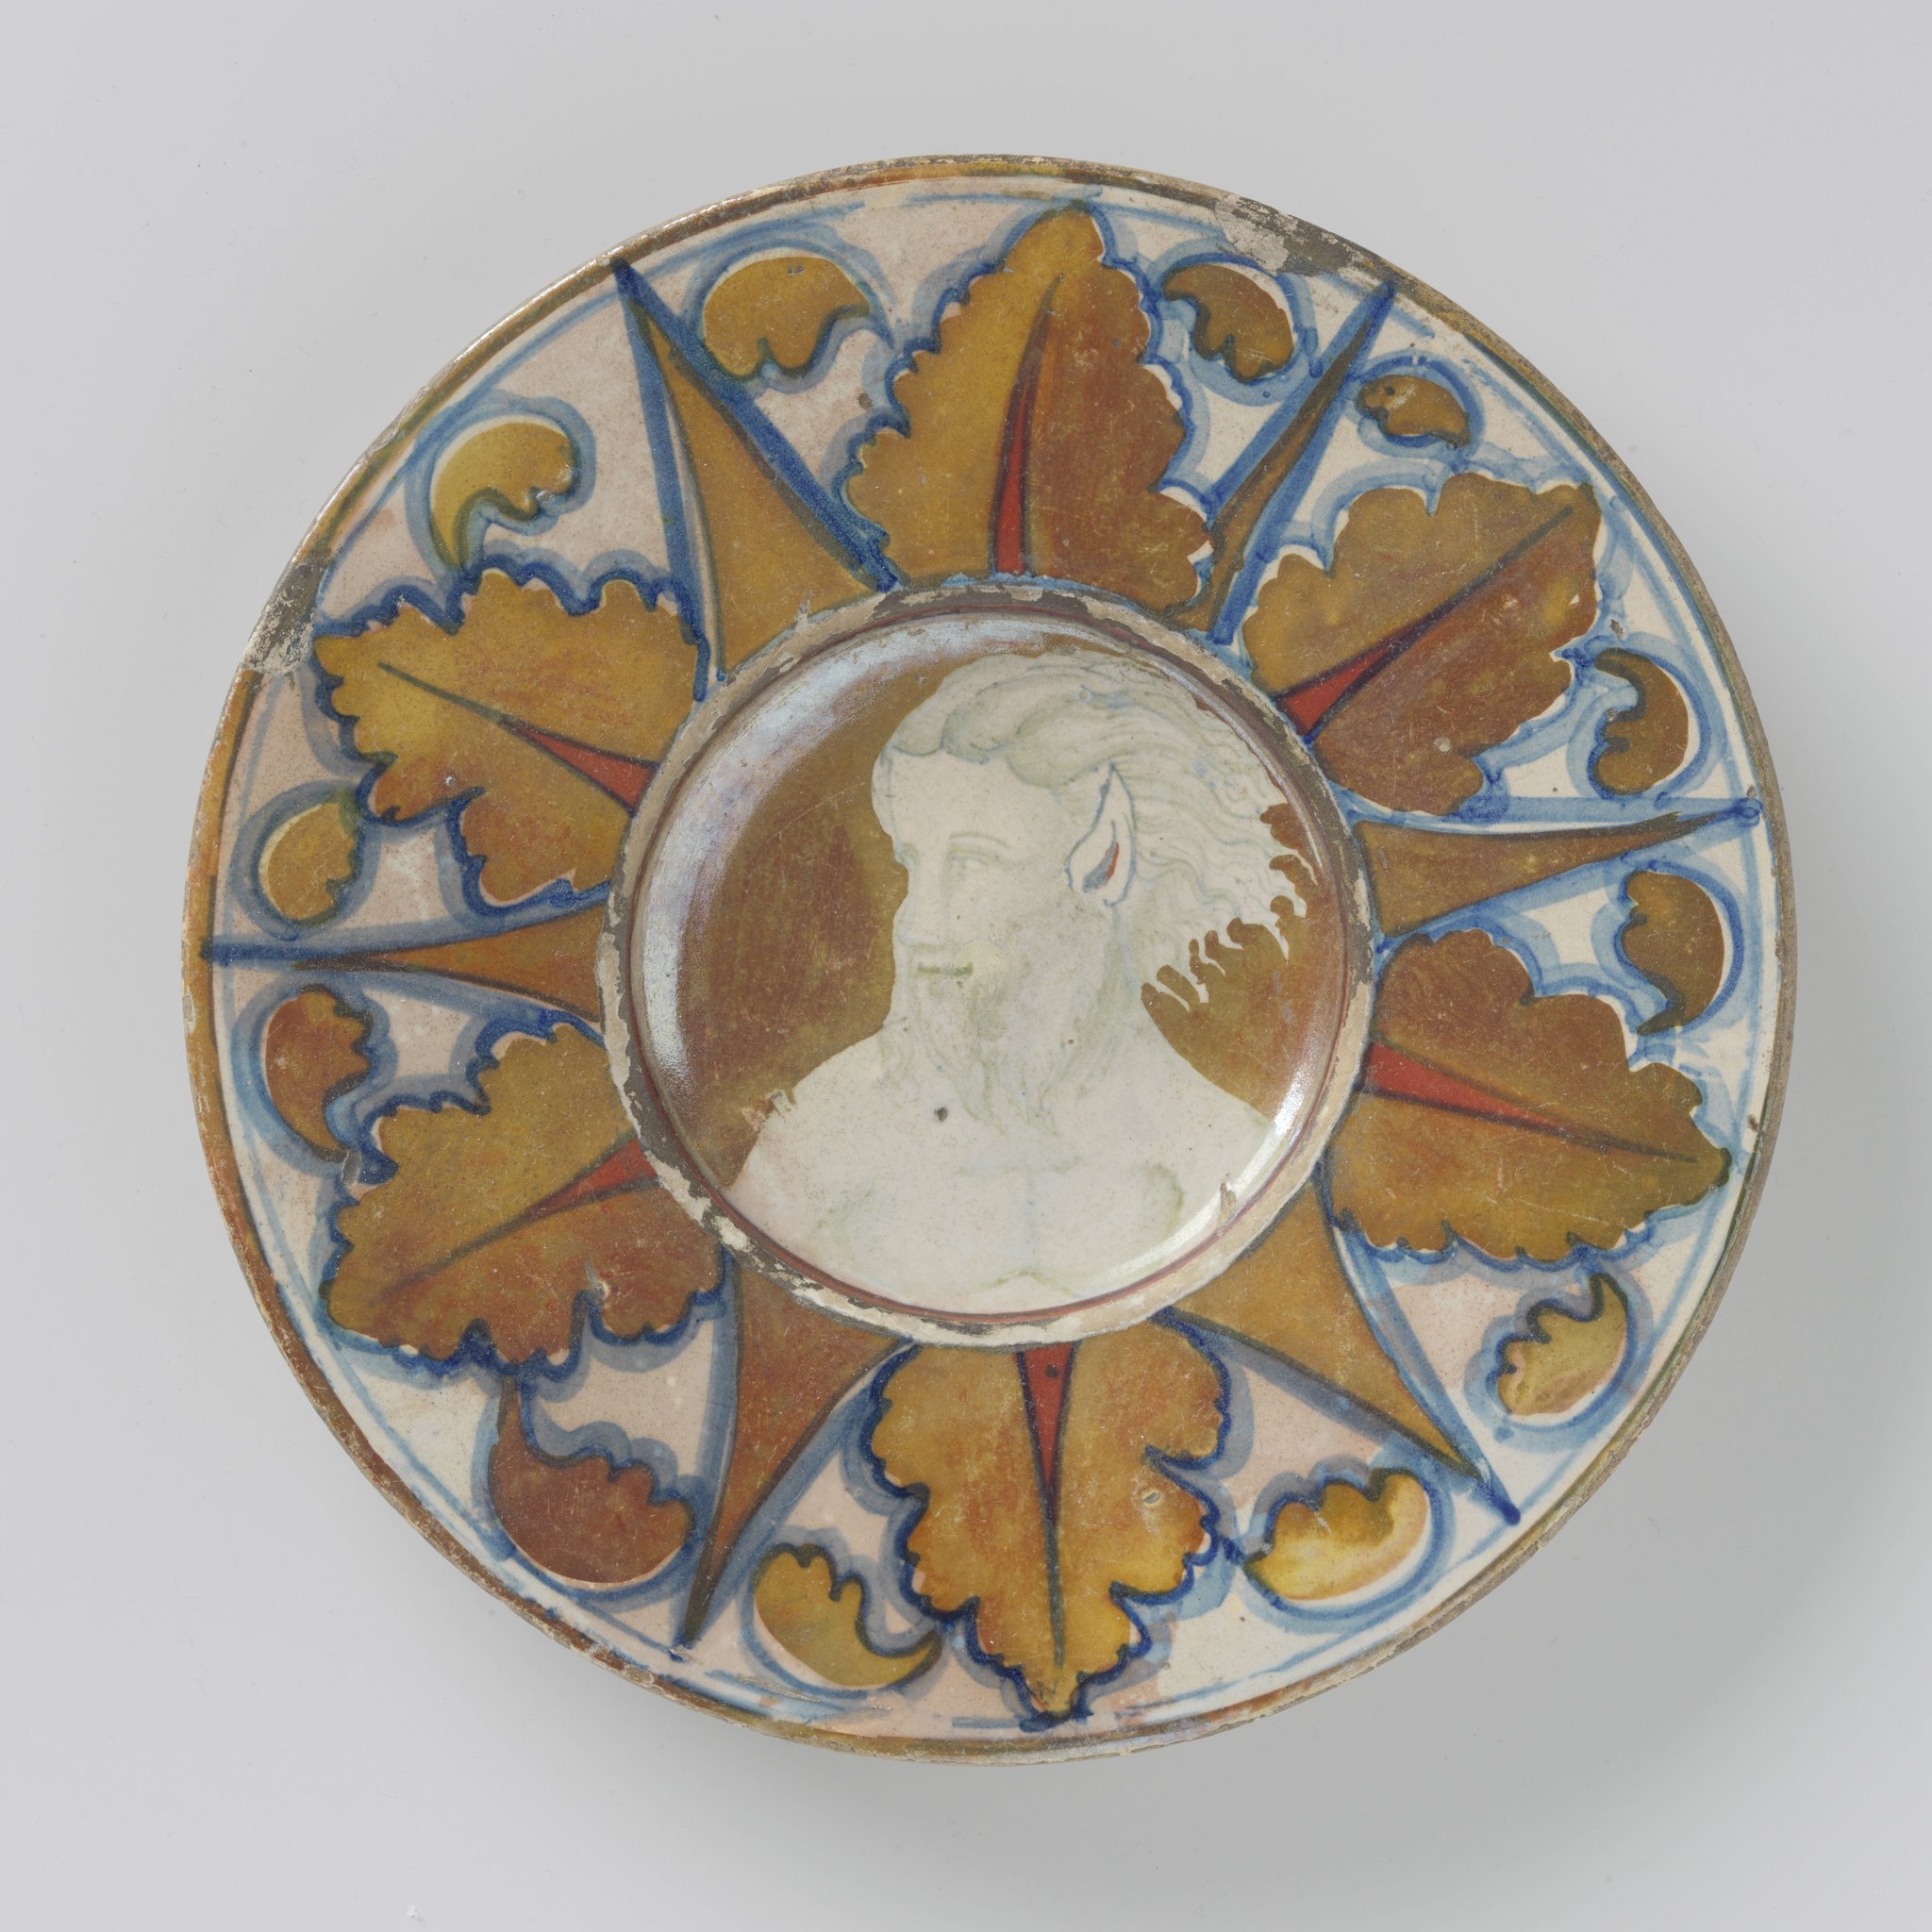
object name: plate dish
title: Bord met verdiept plat, veelkleurig beschilderd met satyr met spitse oren en baard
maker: Anonymous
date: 1520-1530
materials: earthenware, glaze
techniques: maiolica, painted, polychromy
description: Bord met voorstelling van een satyrkop. Majolica met een extra decoratie in metaalluster. Gubbio, ca. 1520 - 1530.